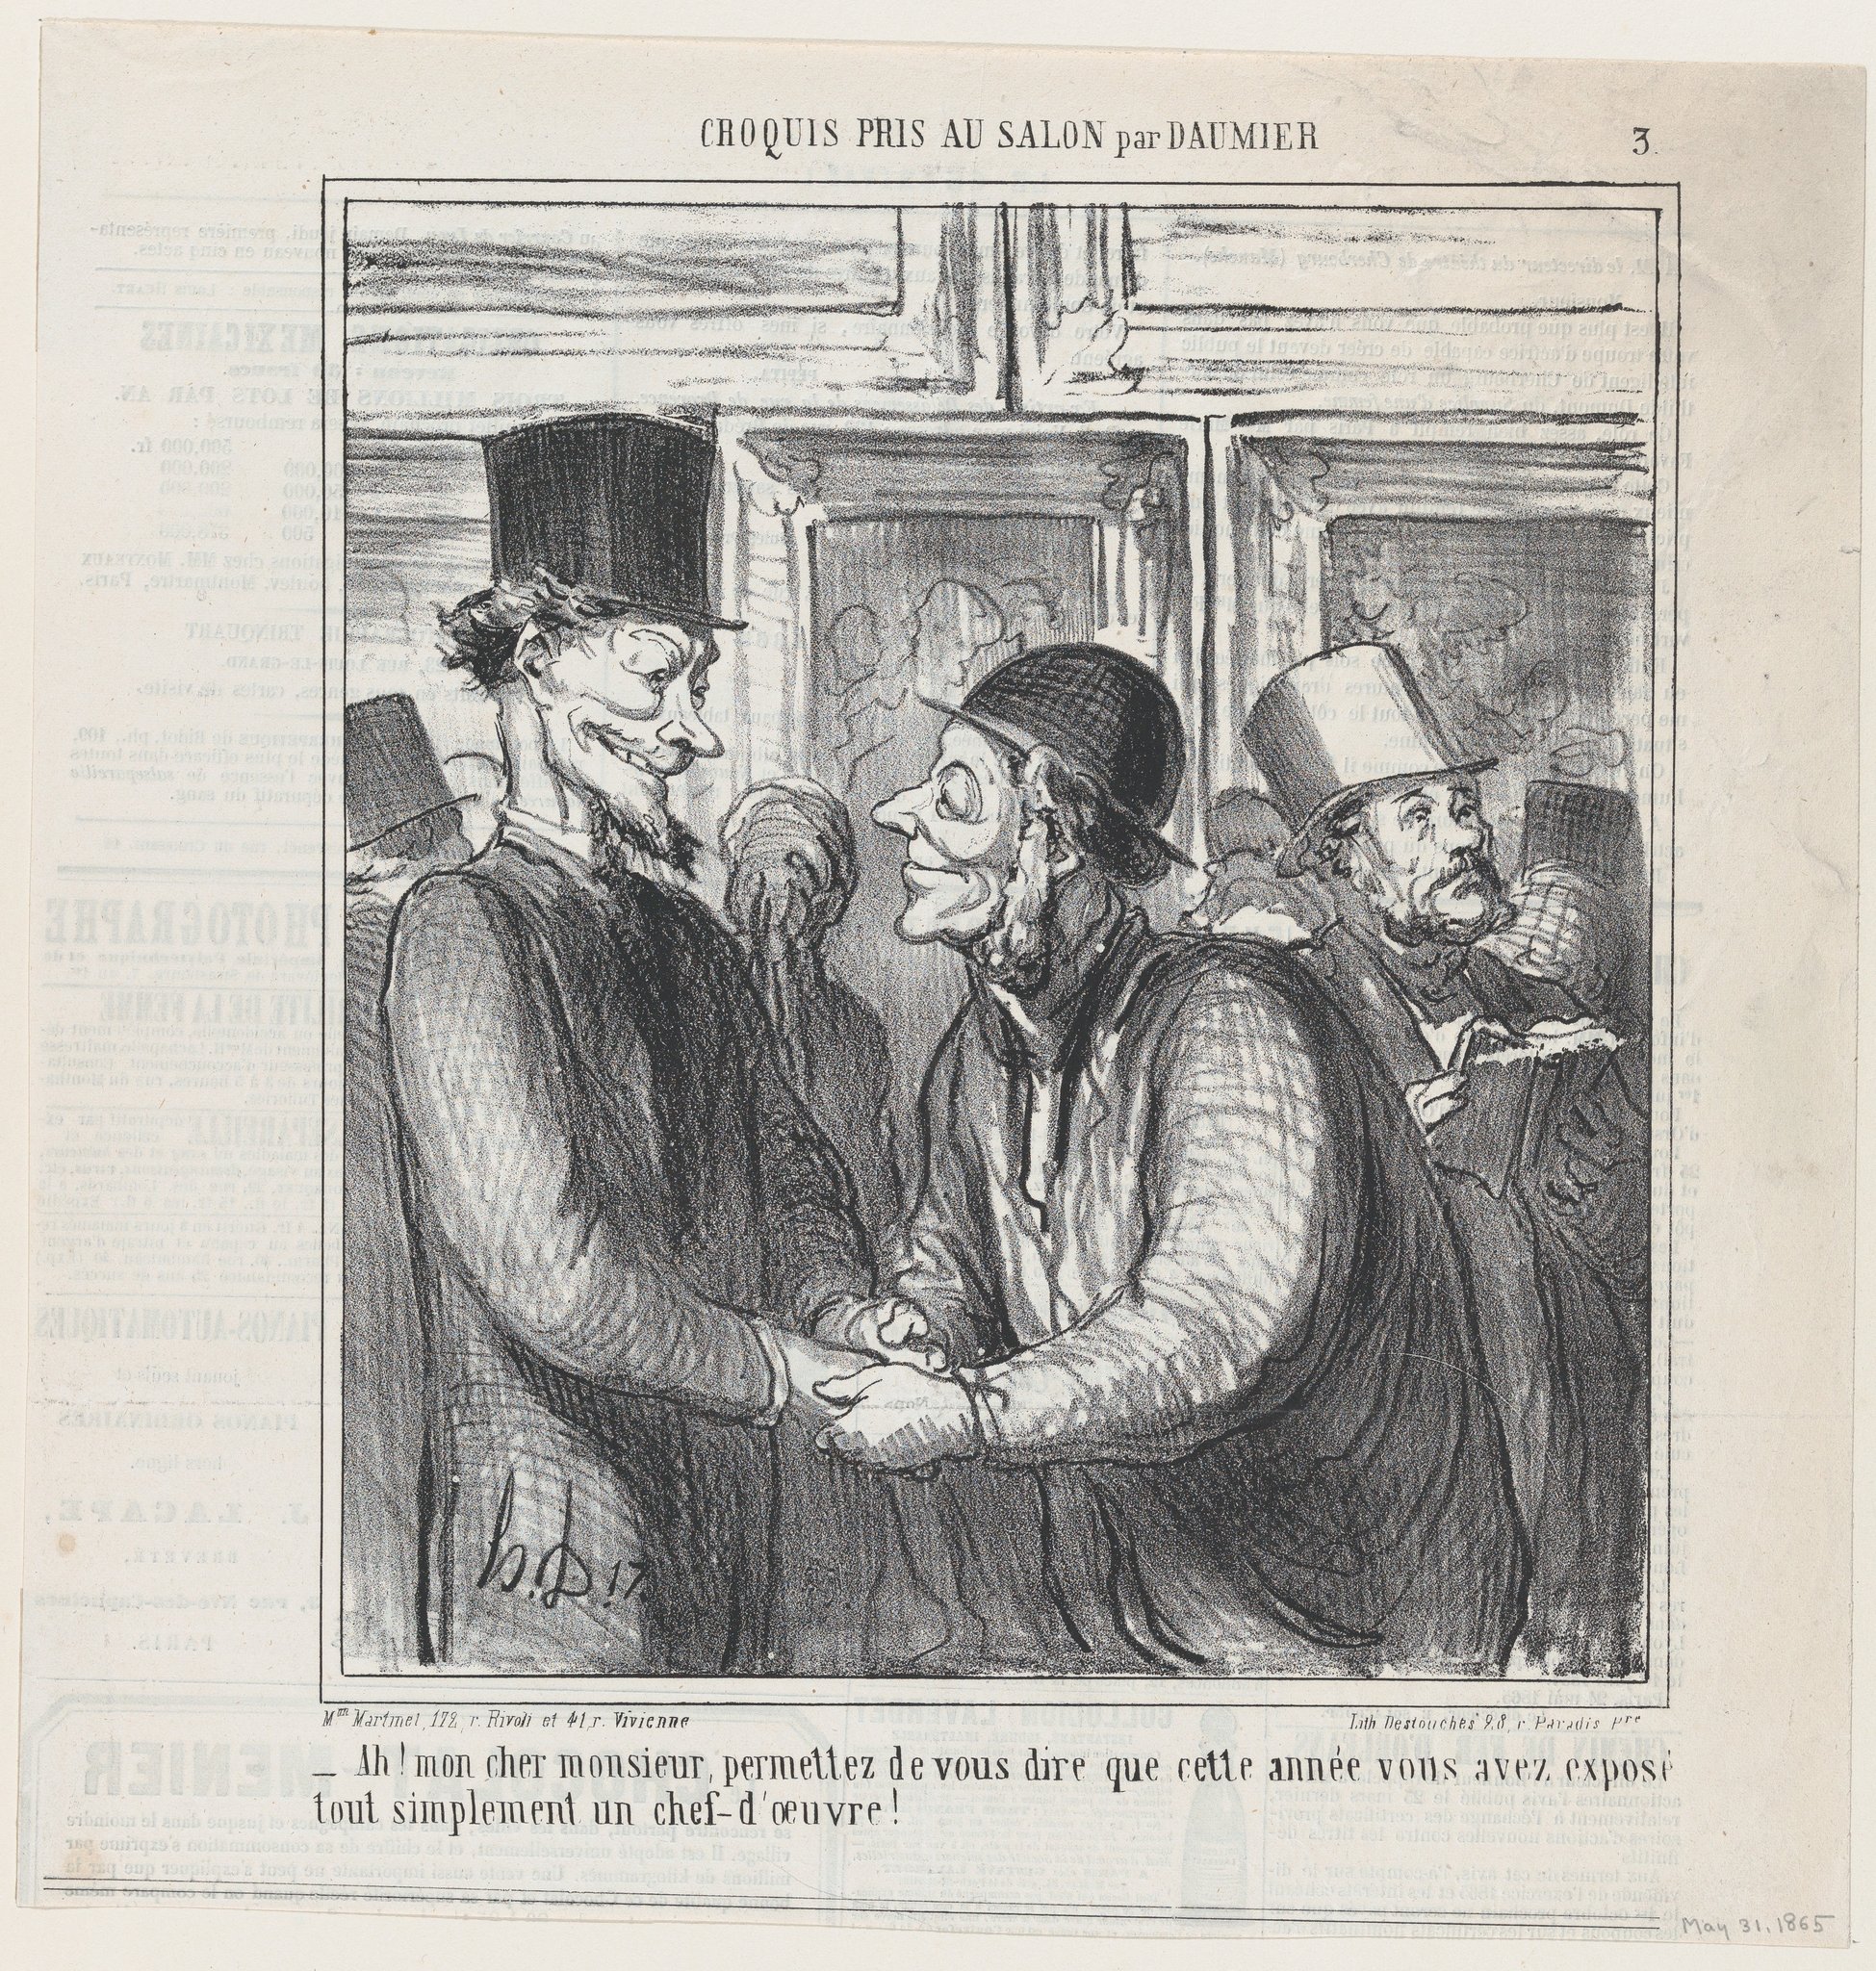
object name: print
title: Ah, my dear sir, allow me to tell you that this year you have quite simply exhibited a masterpiece, from 'Sketches from the Salon,' published in Le Charivari, May 31, 1865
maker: honoré daumier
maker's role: artist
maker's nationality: french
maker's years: 1808-1879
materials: paper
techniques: lithograph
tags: satire,men